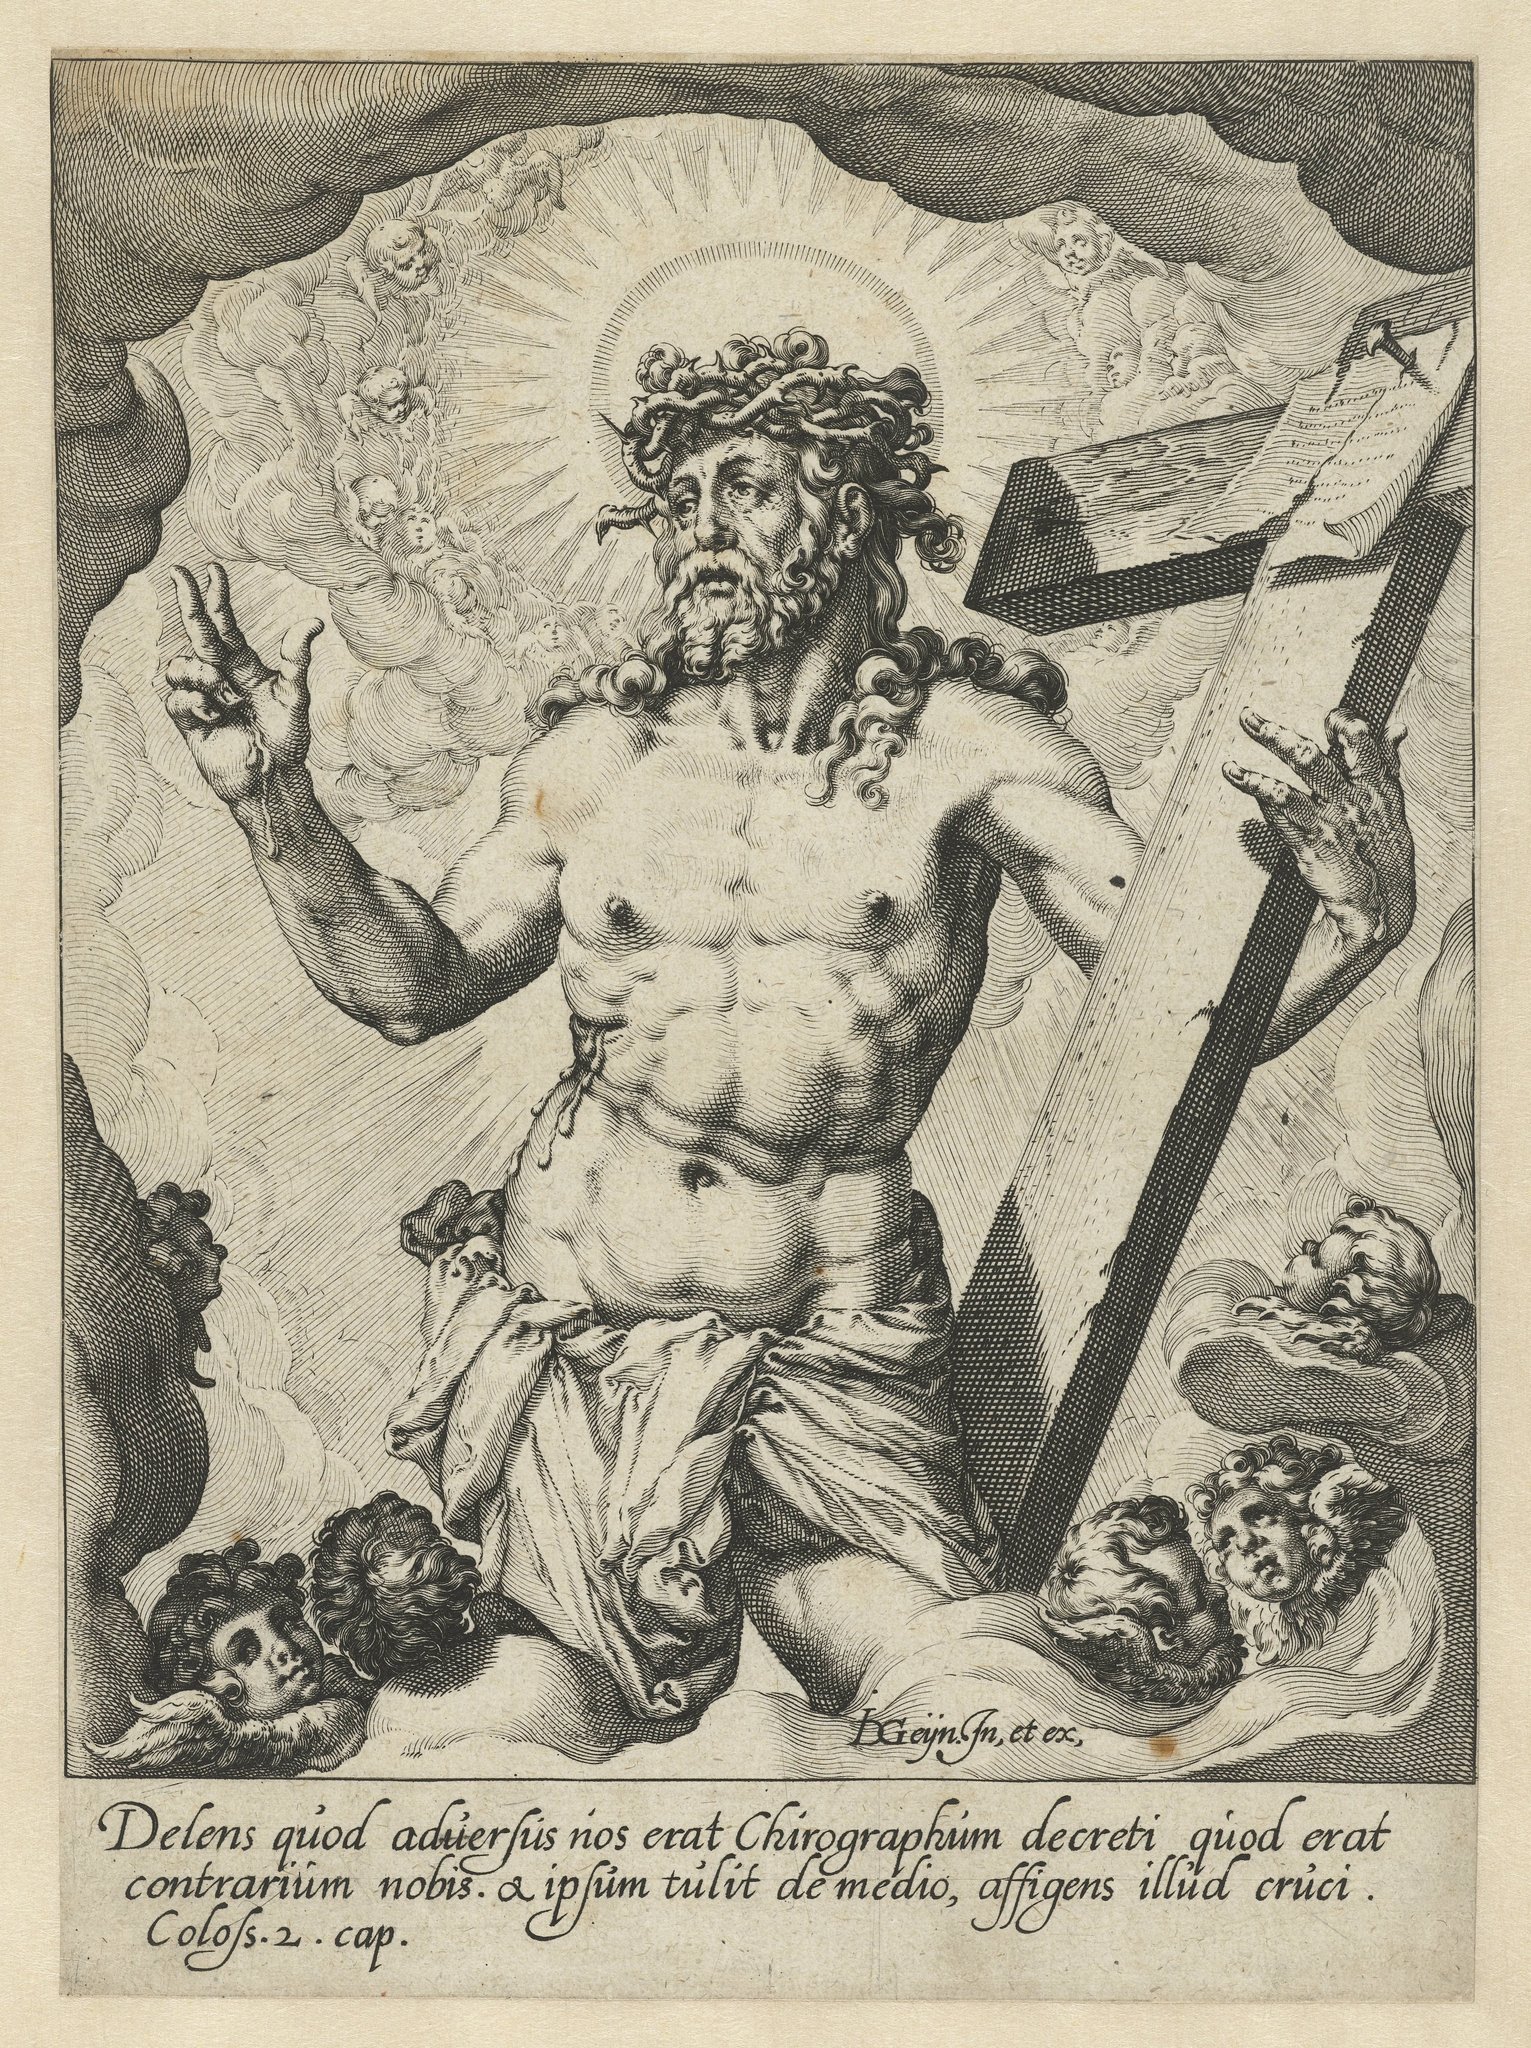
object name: print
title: Christus als Man van Smarten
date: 1593-1597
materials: paper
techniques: engraving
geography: netherlands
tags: man of sorrows, 'imago pietatis', 'erbärmdebild', 'schmerzensmann'; the upright christ showing his wounds, usually bearing the crown of thorns, and accompanied by the instruments of the passion, standing or sitting in his tomb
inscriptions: collector's mark: Lugt 2228a, collector's mark: Lugt 2760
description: Christus, omgeven door engelen, staand, ten halven lijve, de rechterhand opgeheven, in de linkerhand het kruis, op het hoofd de doornenkroon. Onder de voorstelling drie regels Latijnse tekst (Kolossenzen 2).